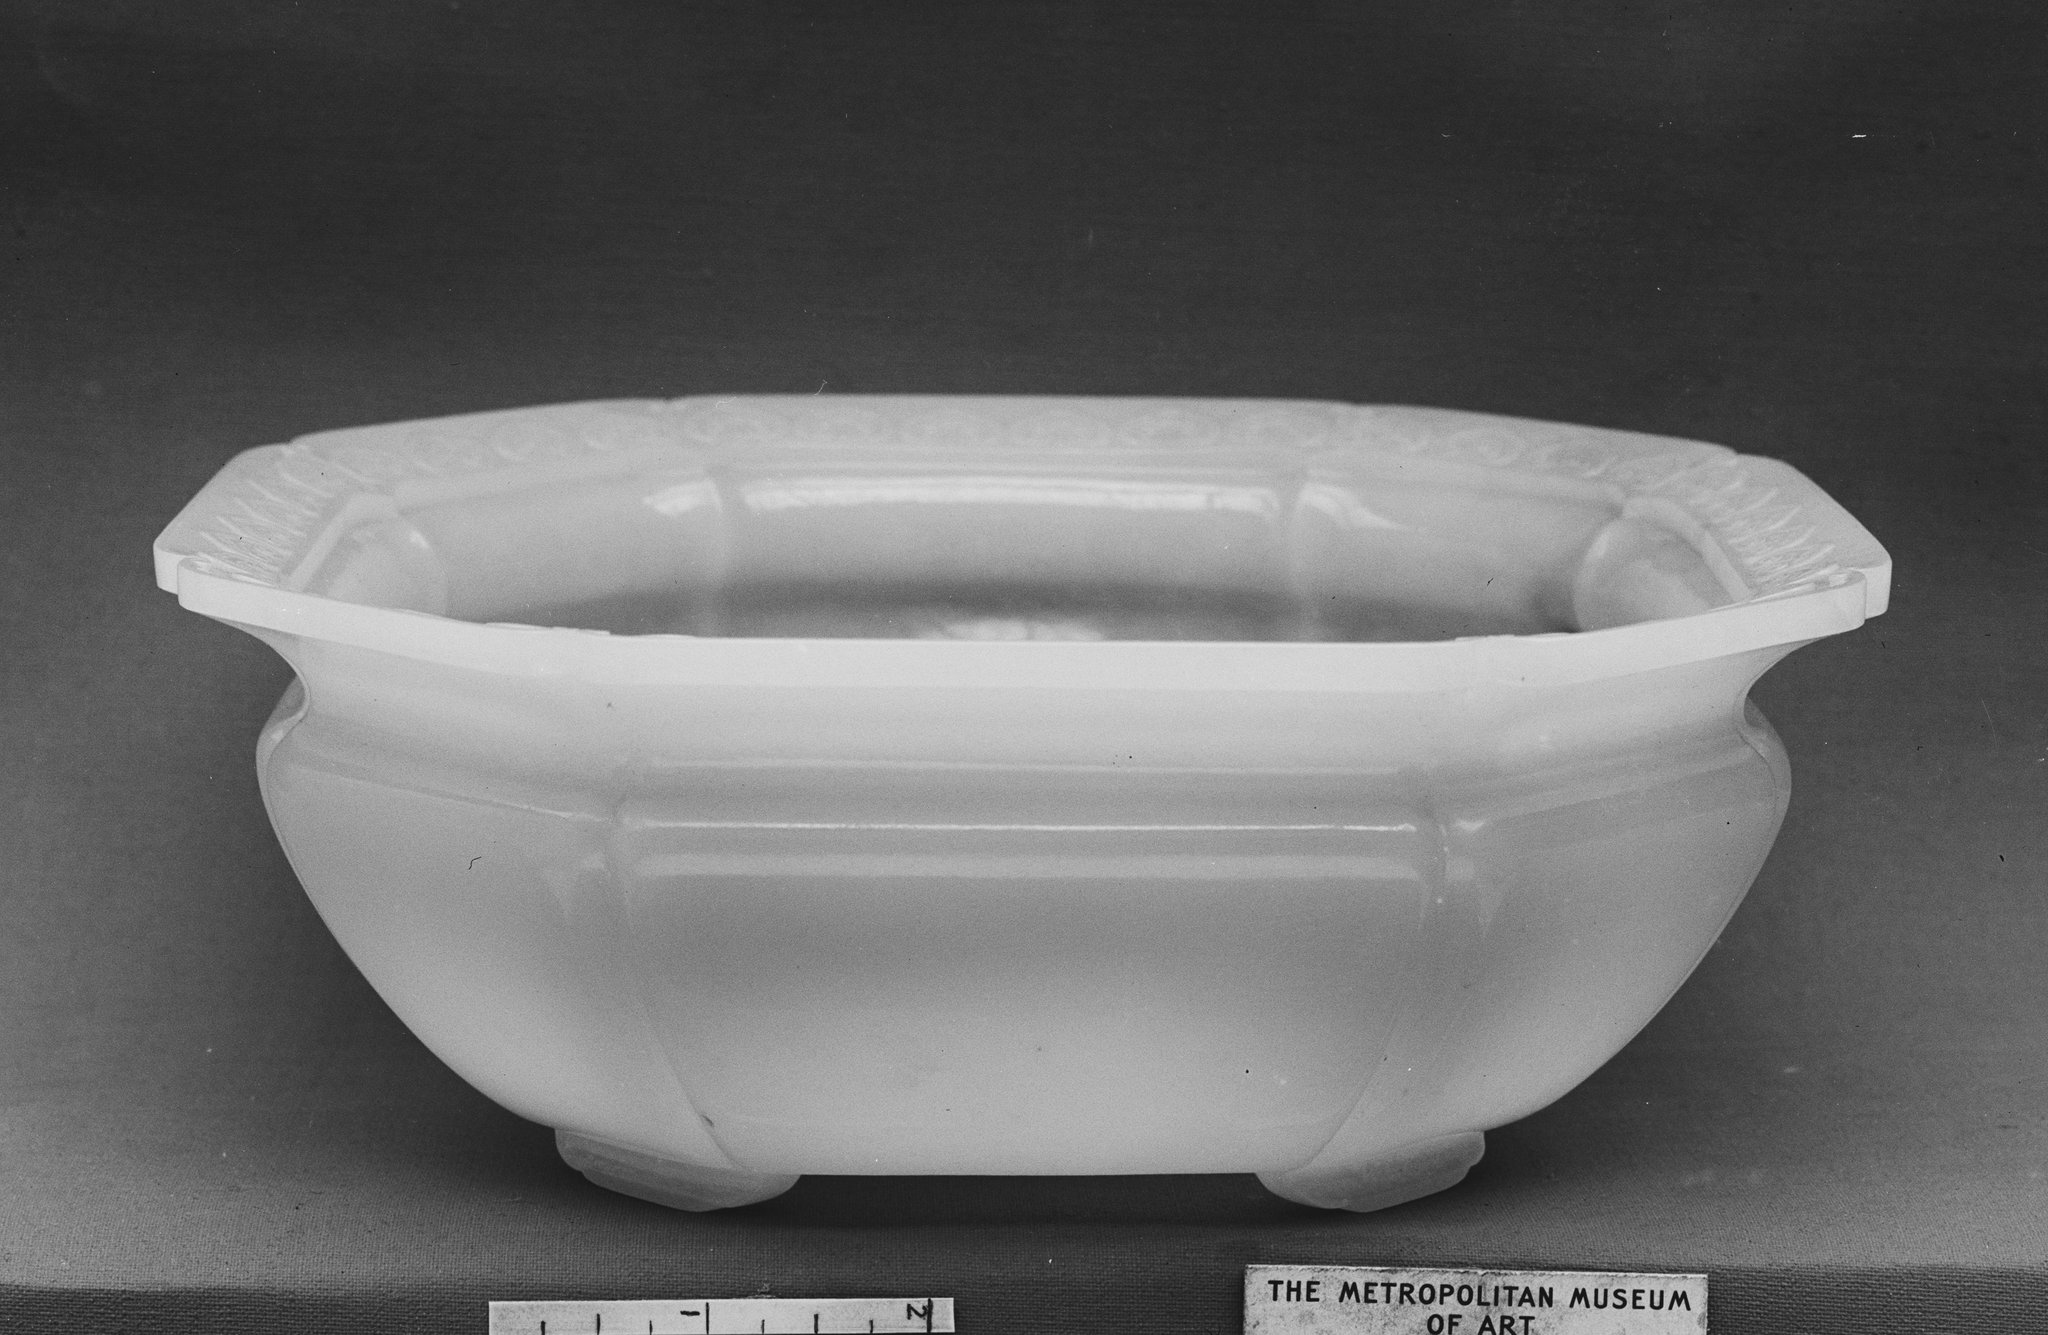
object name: bowl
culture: chinese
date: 1701-1800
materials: jade